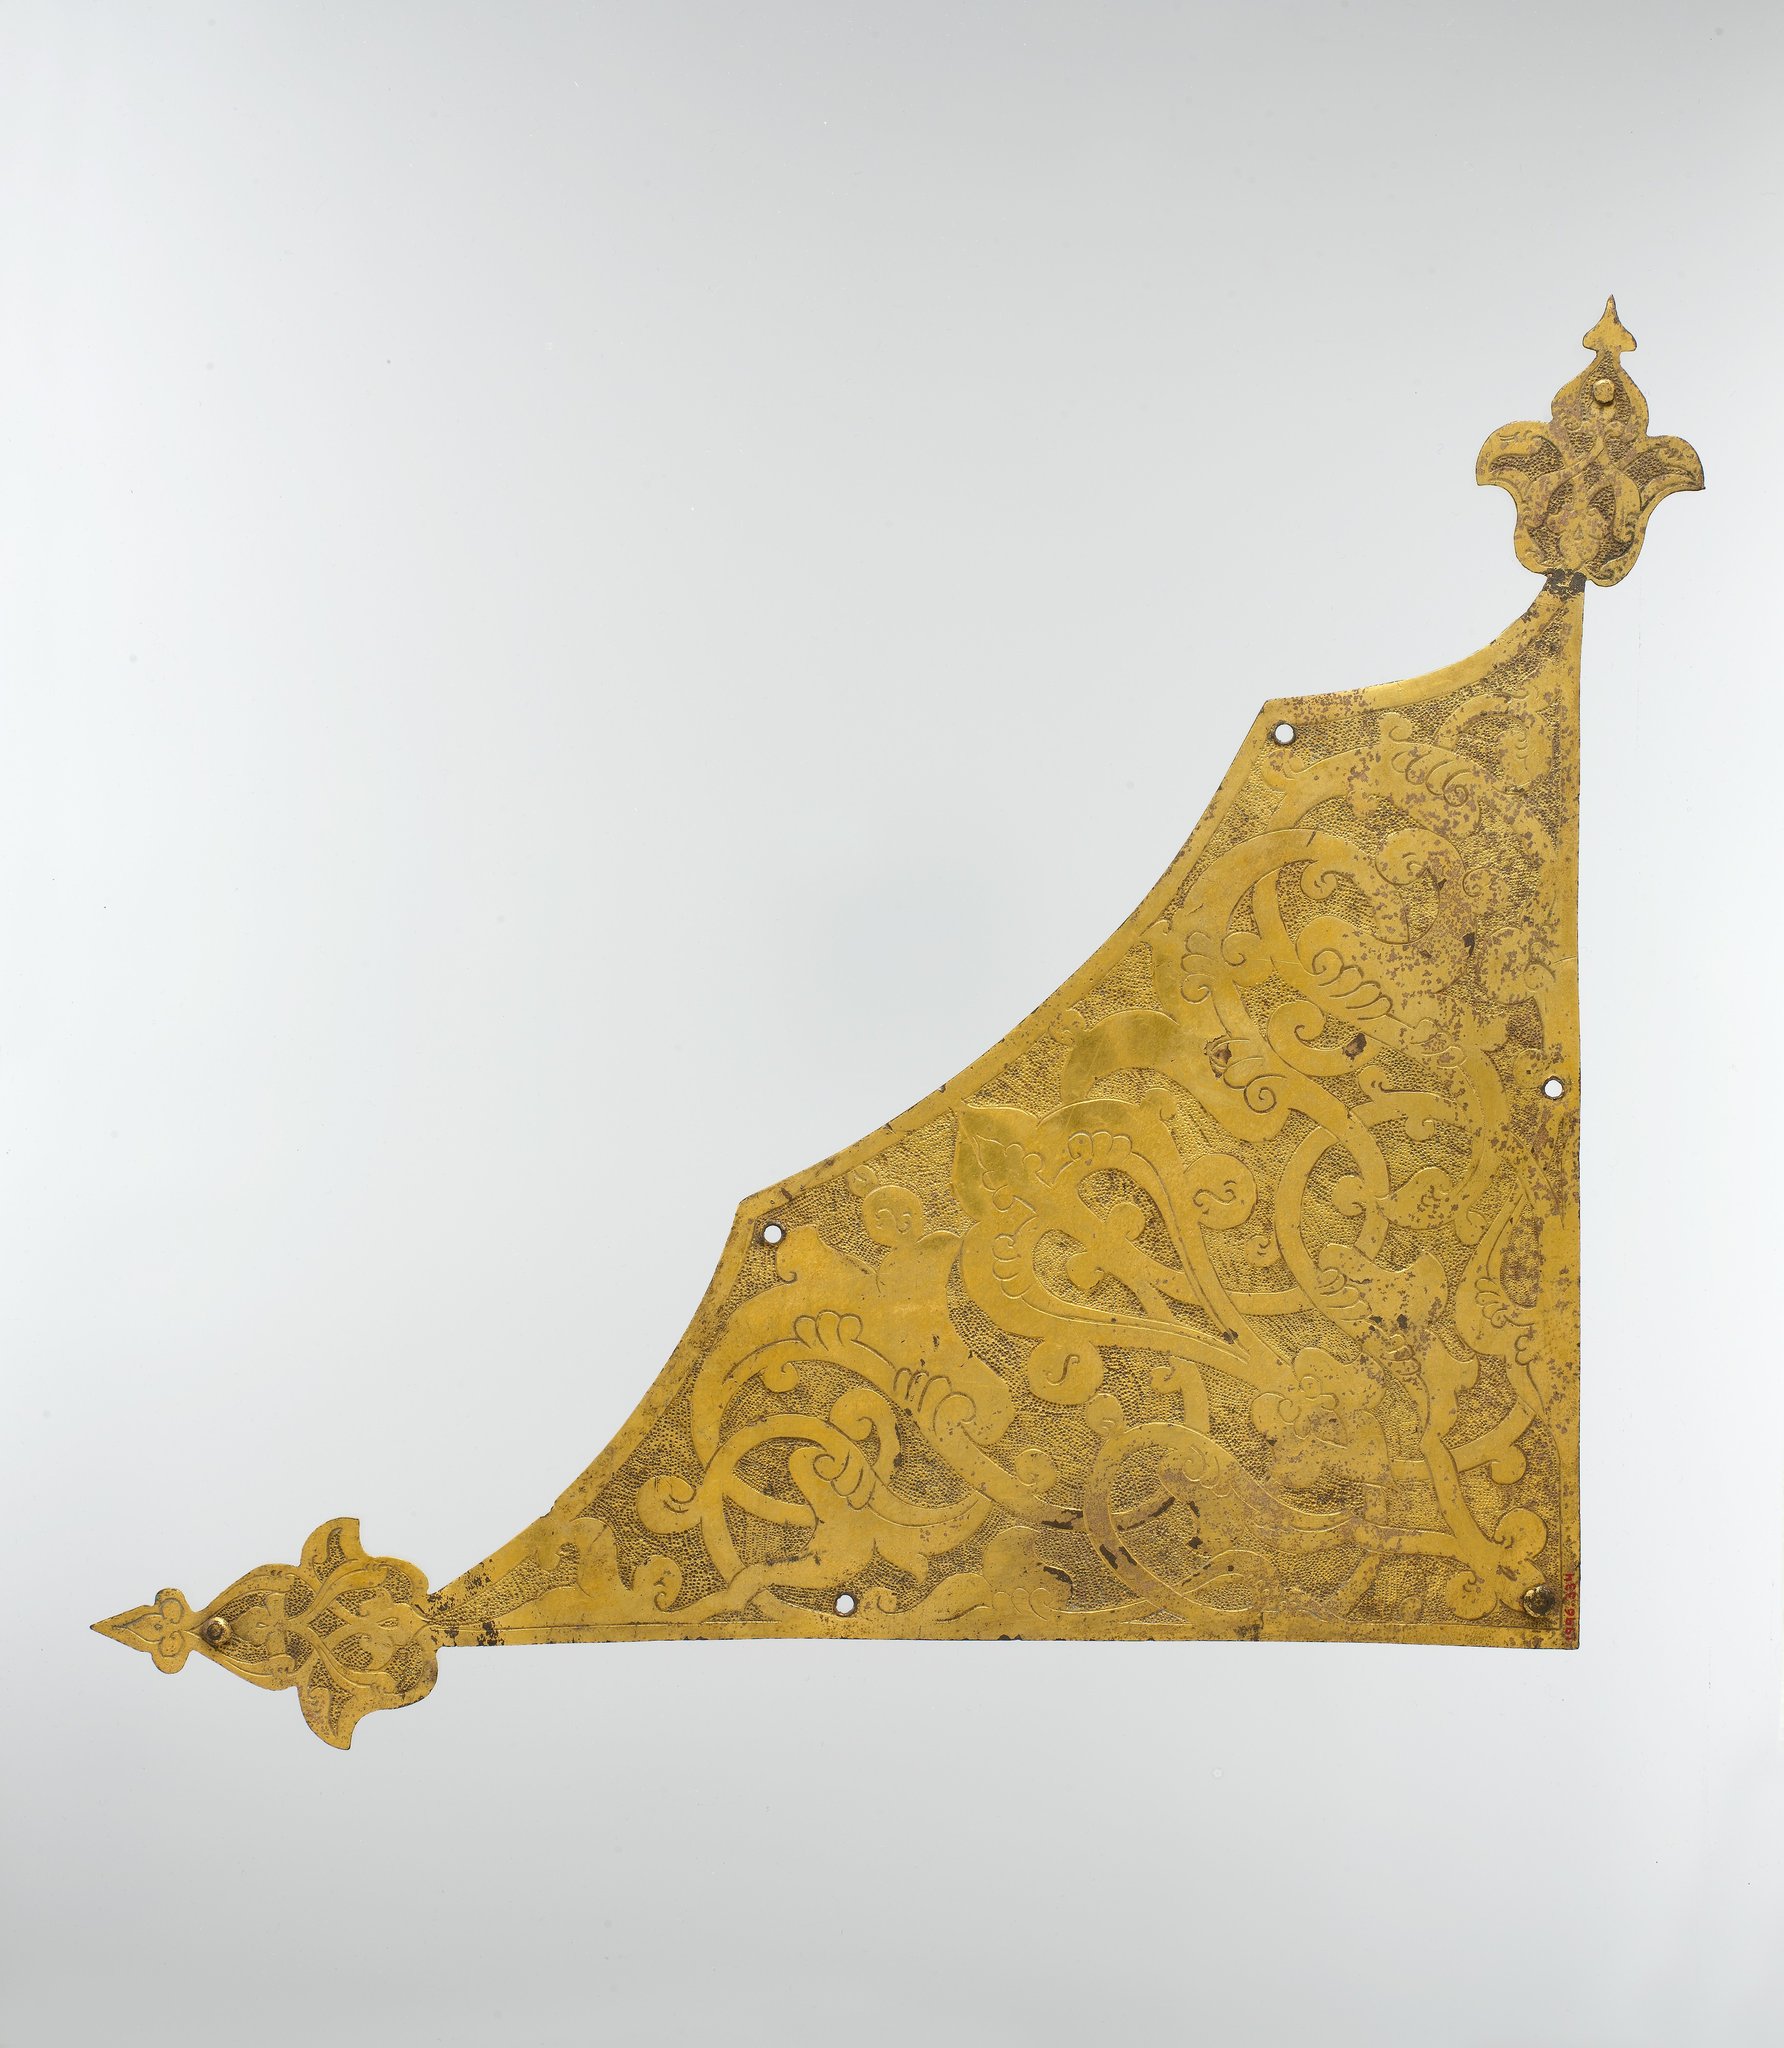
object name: plaque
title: Tombak Gilded Plaque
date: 1501-1600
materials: copper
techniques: chasing, engraving, gilding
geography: turkey